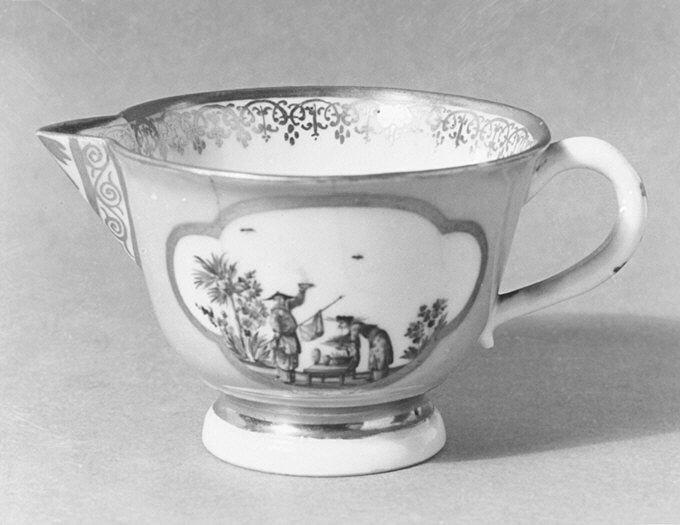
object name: cup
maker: meissen manufactory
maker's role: manufactory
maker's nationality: german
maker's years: 1710-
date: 1730-1735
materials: hard paste porcelain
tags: men